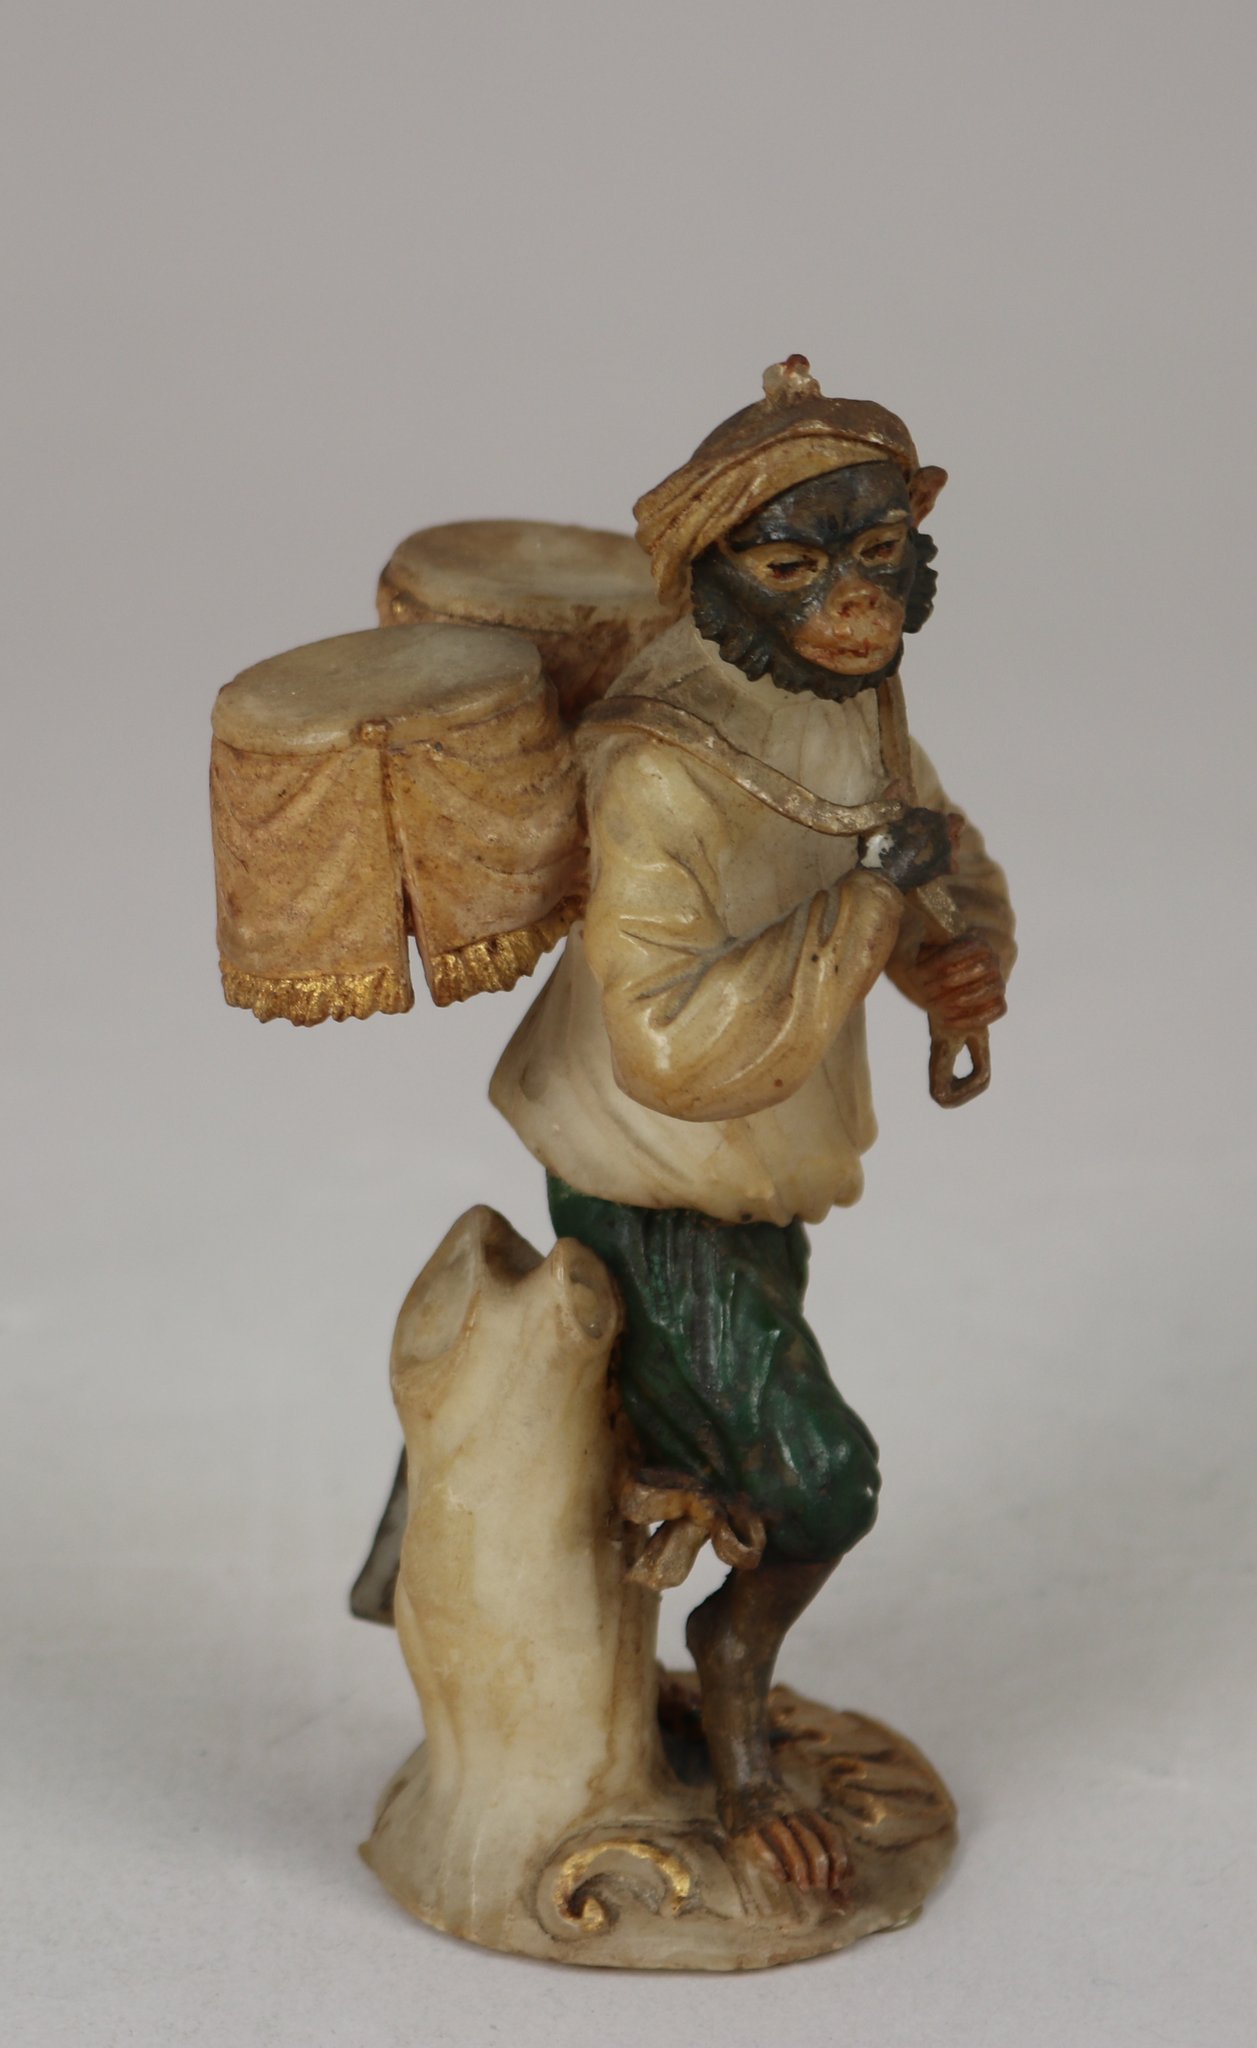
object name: statuette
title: Statuette belonging to a monkey orchestra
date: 1745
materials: alabaster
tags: monkeys